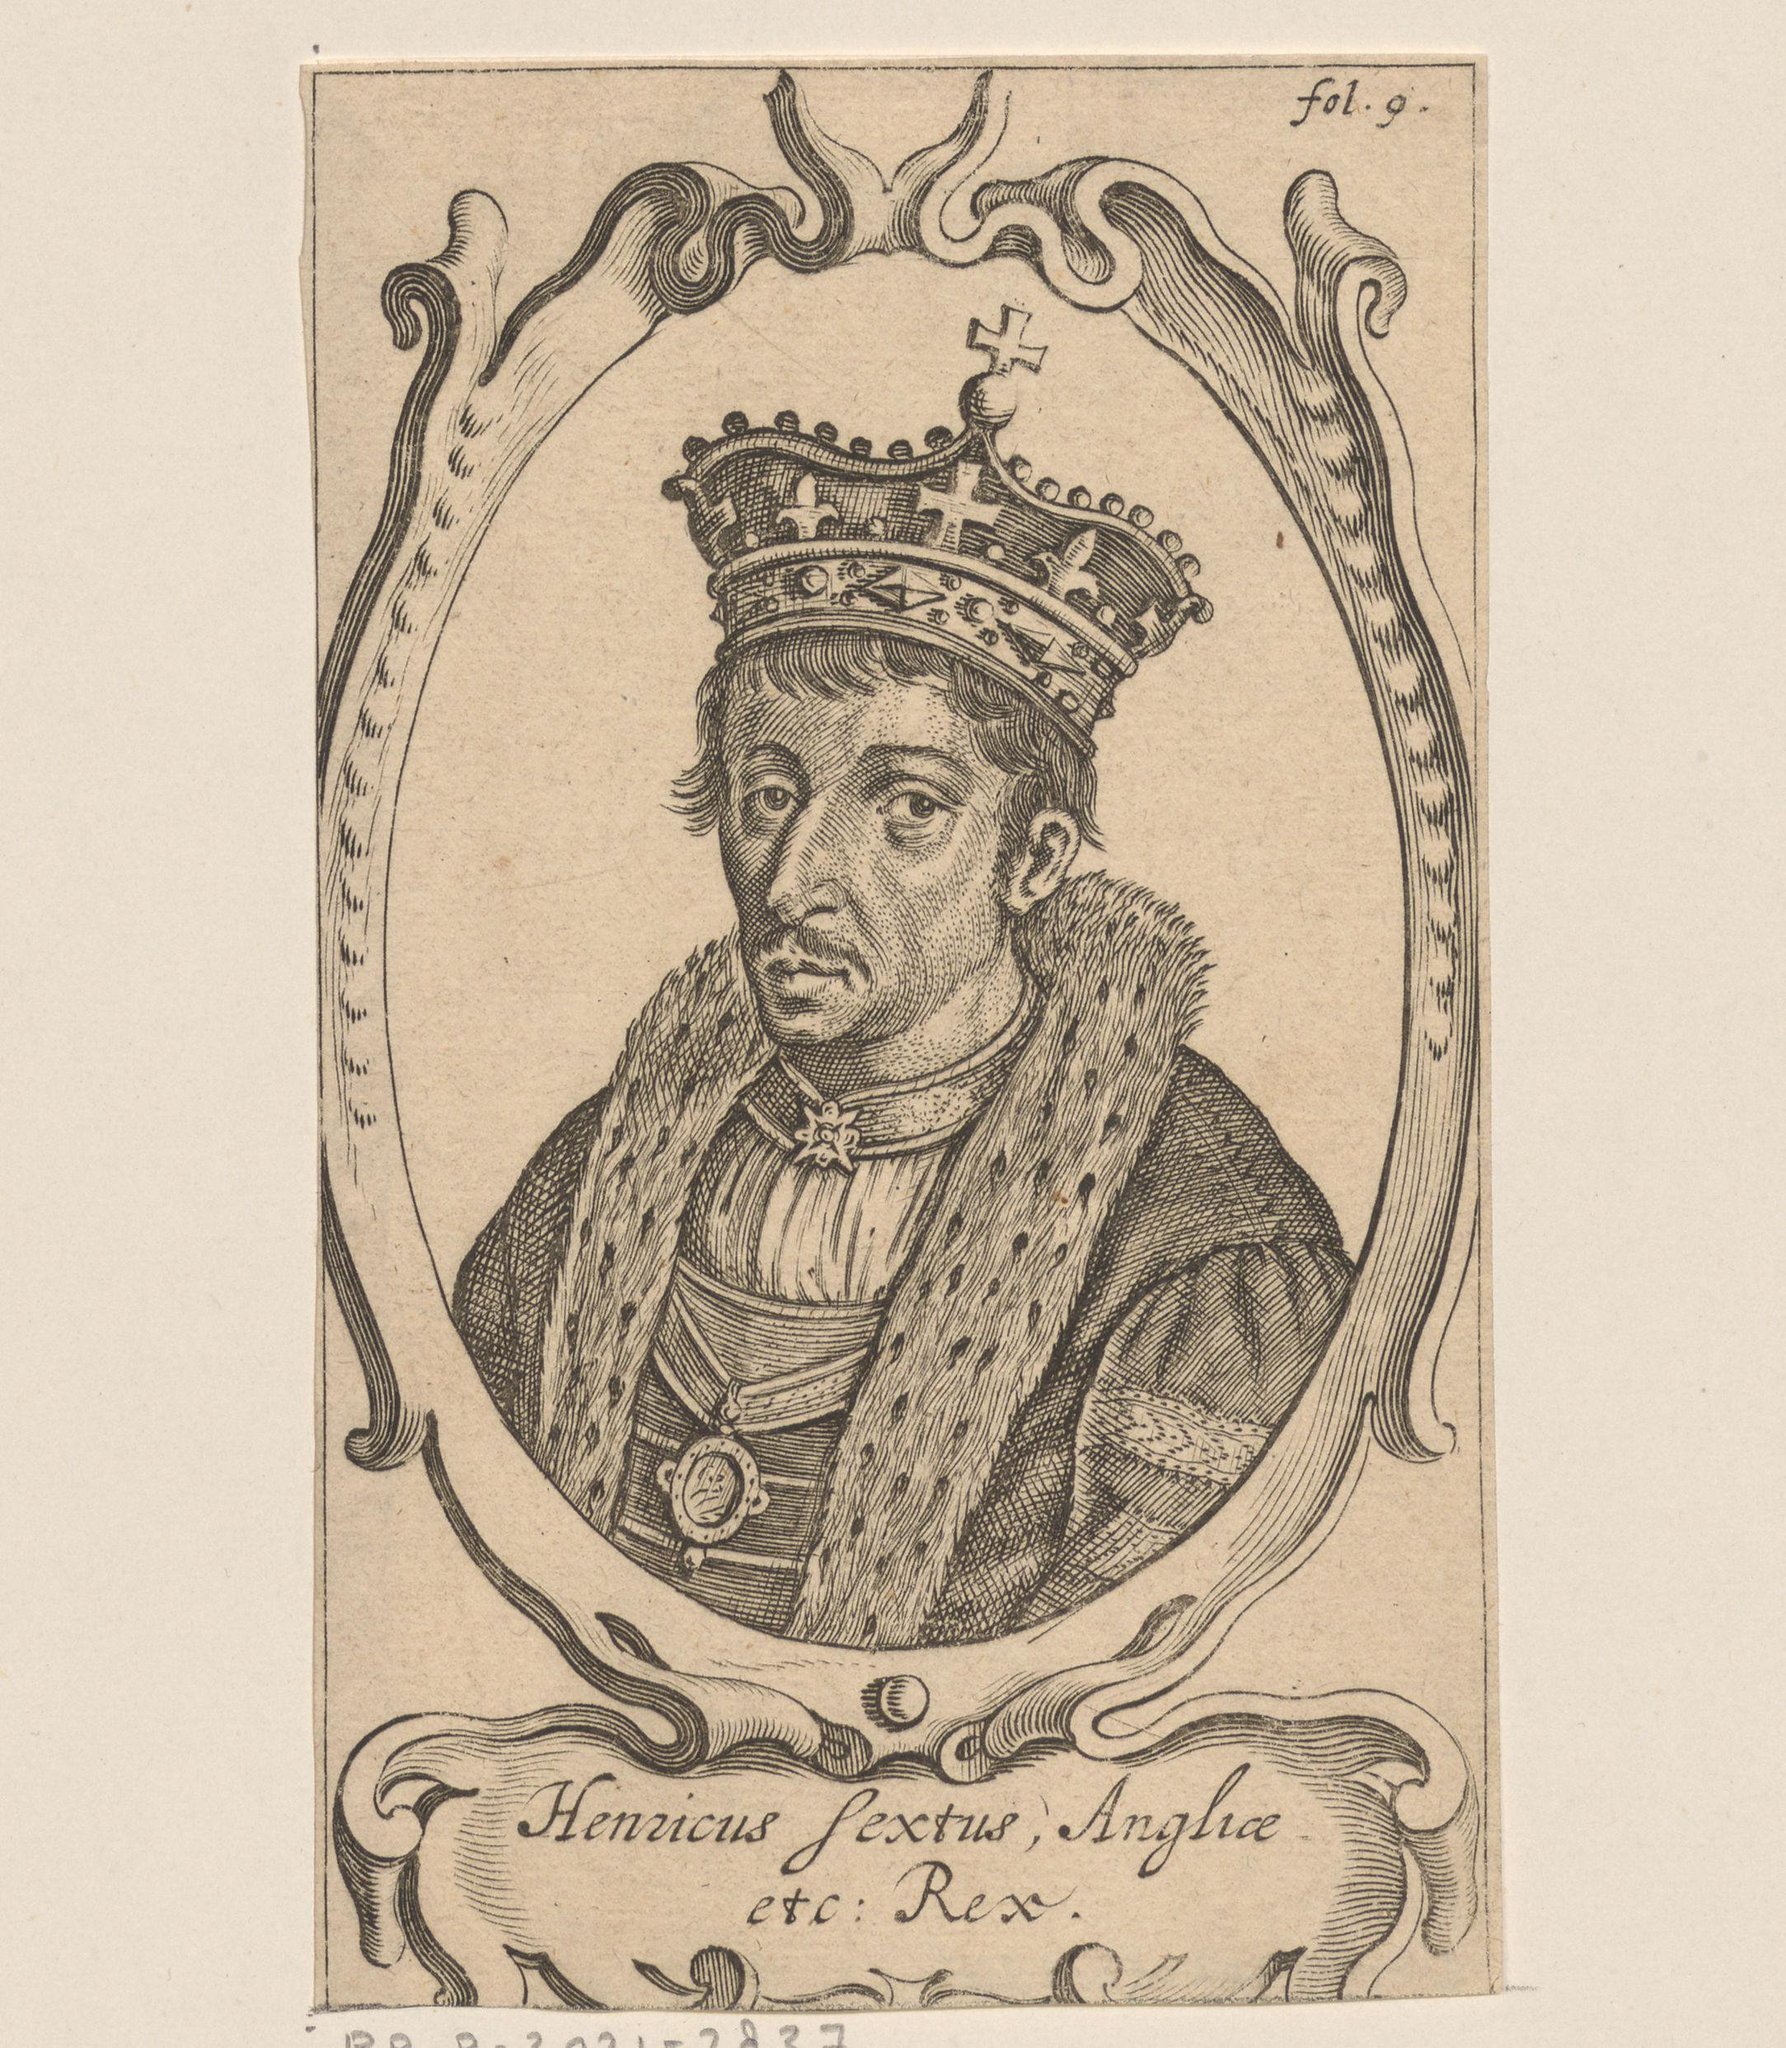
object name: book illustration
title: Portret van Hendrik VI, koning van Engeland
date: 1660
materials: paper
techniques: engraving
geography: amsterdam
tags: london, historical persons, king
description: Prent uit: Bos, Lambert van den. Het vorstelick treur-toonneel, of op- en onder-gang der grooten. Amsterdam: Abraham Wolfgang, 1660.